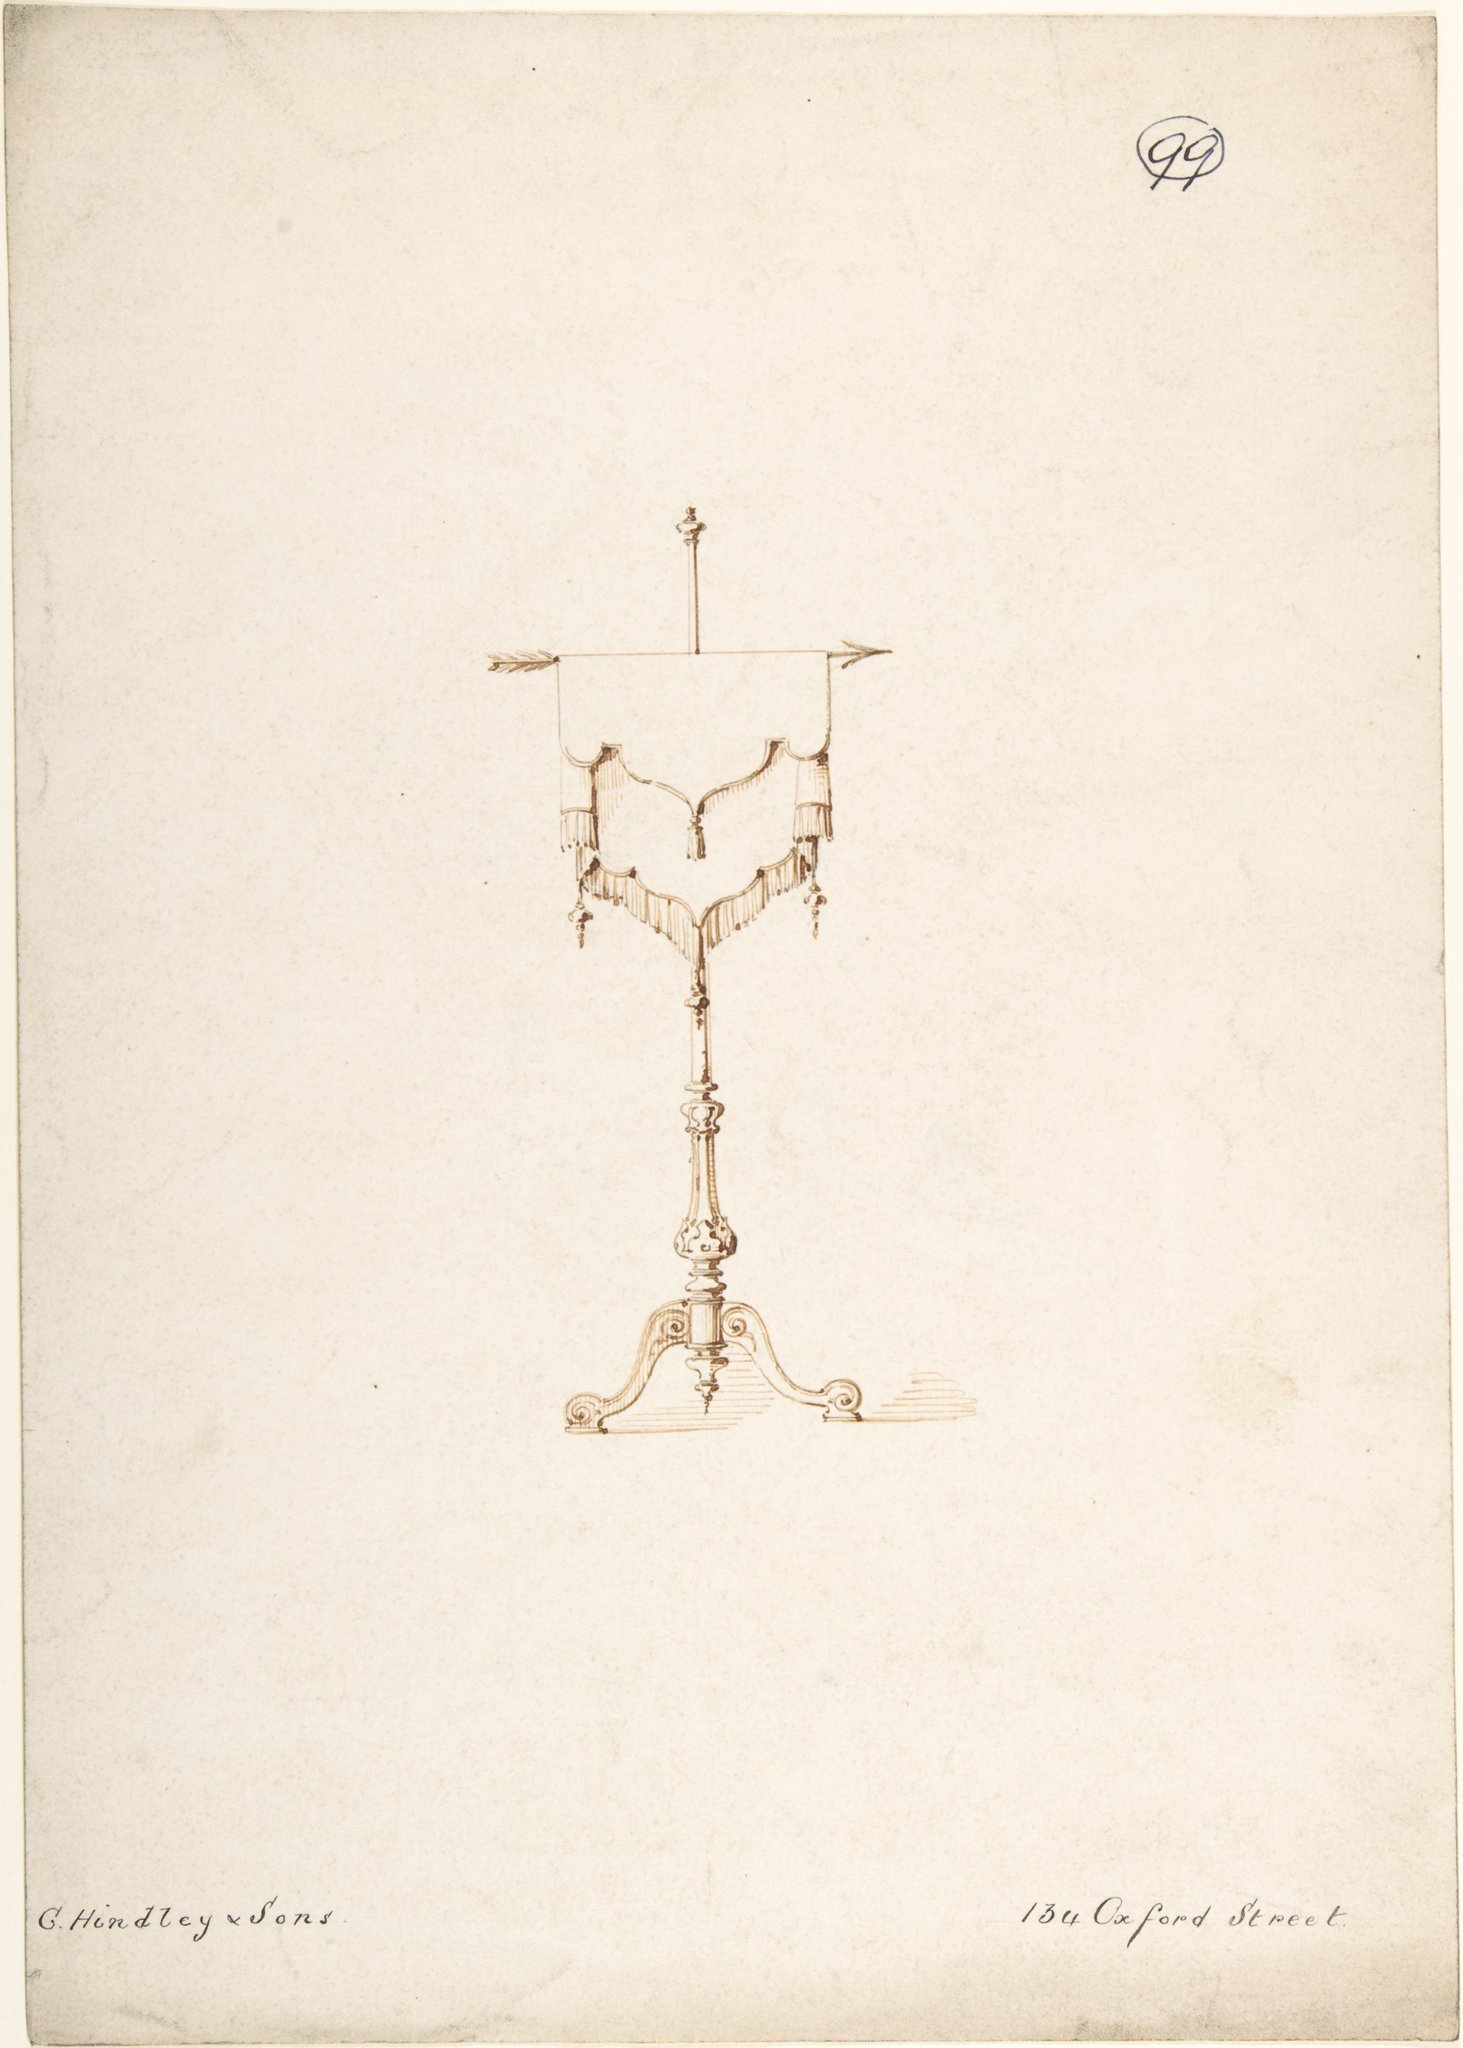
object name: drawing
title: Design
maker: charles hindley and sons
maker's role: artist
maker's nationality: british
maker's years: 1841-1917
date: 1841-1884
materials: graphite, ink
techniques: pen